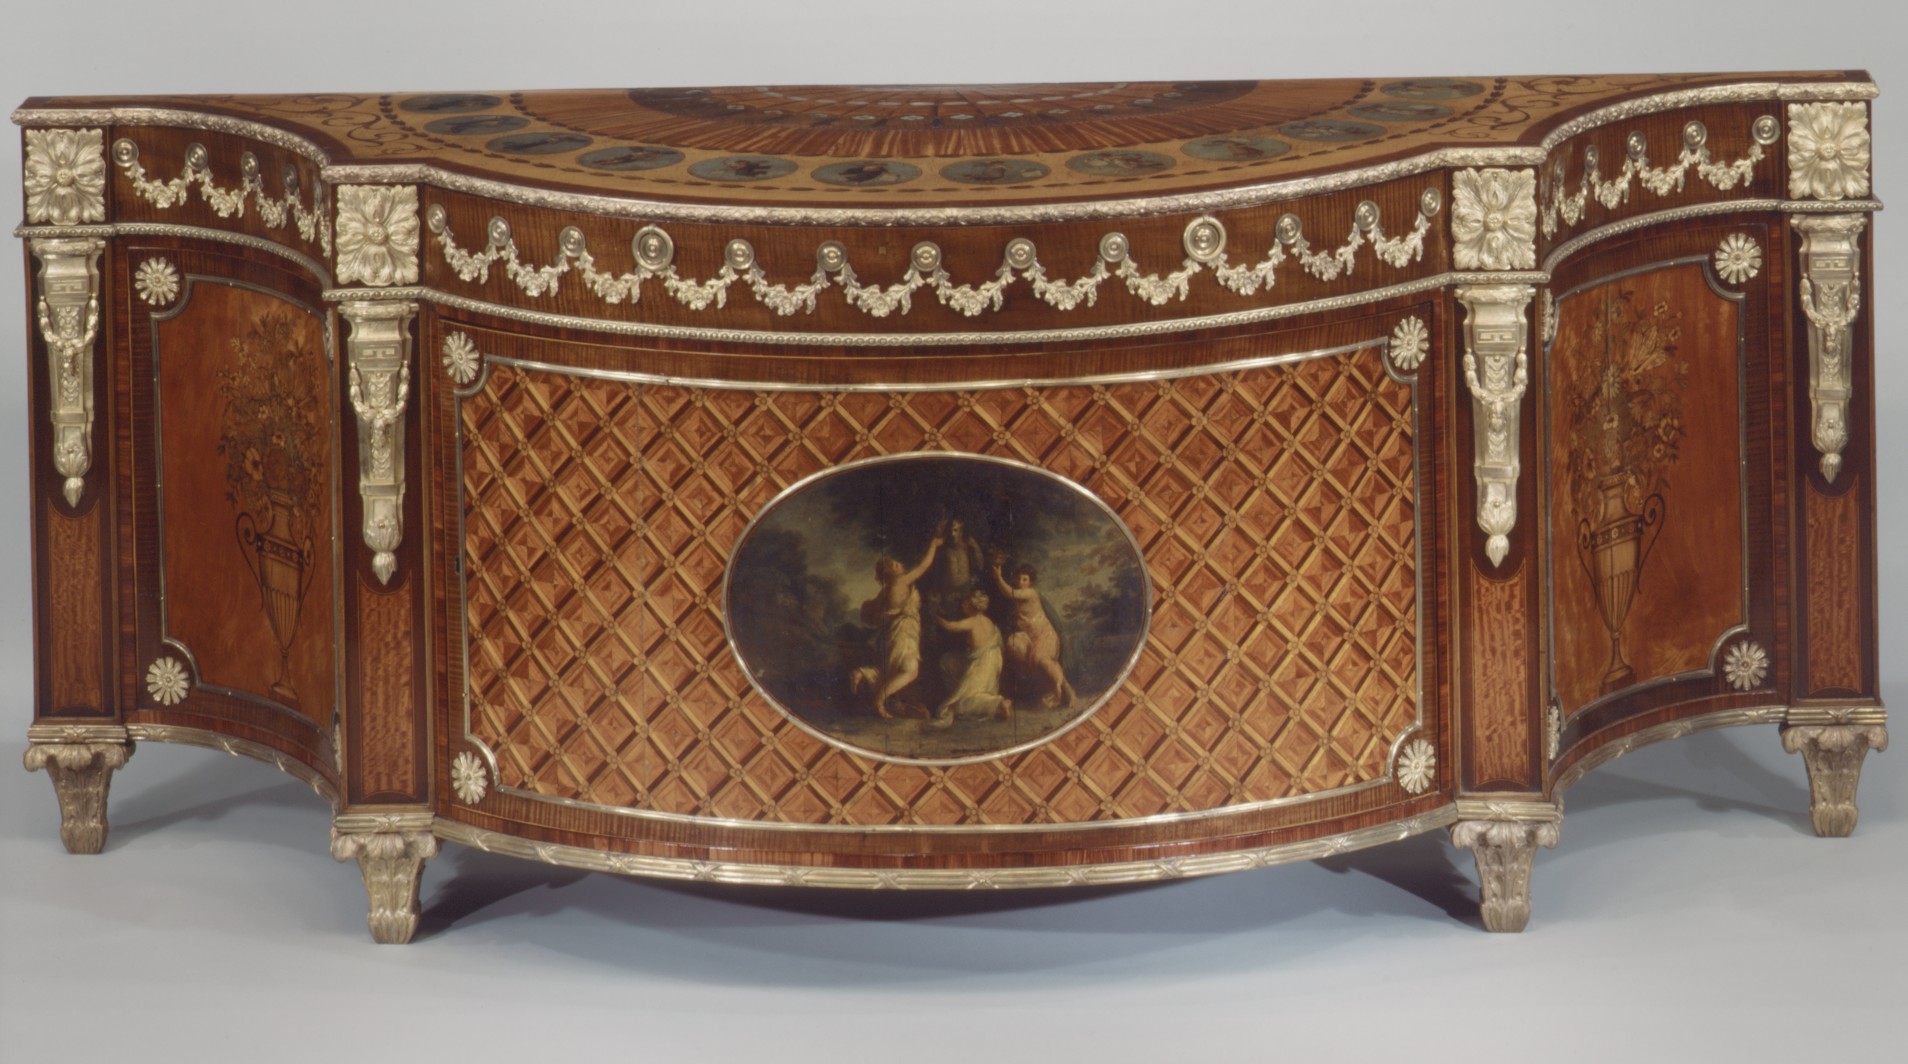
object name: commode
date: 1780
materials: gilt bronze, wood, mother of pearl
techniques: veneering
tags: nymphs